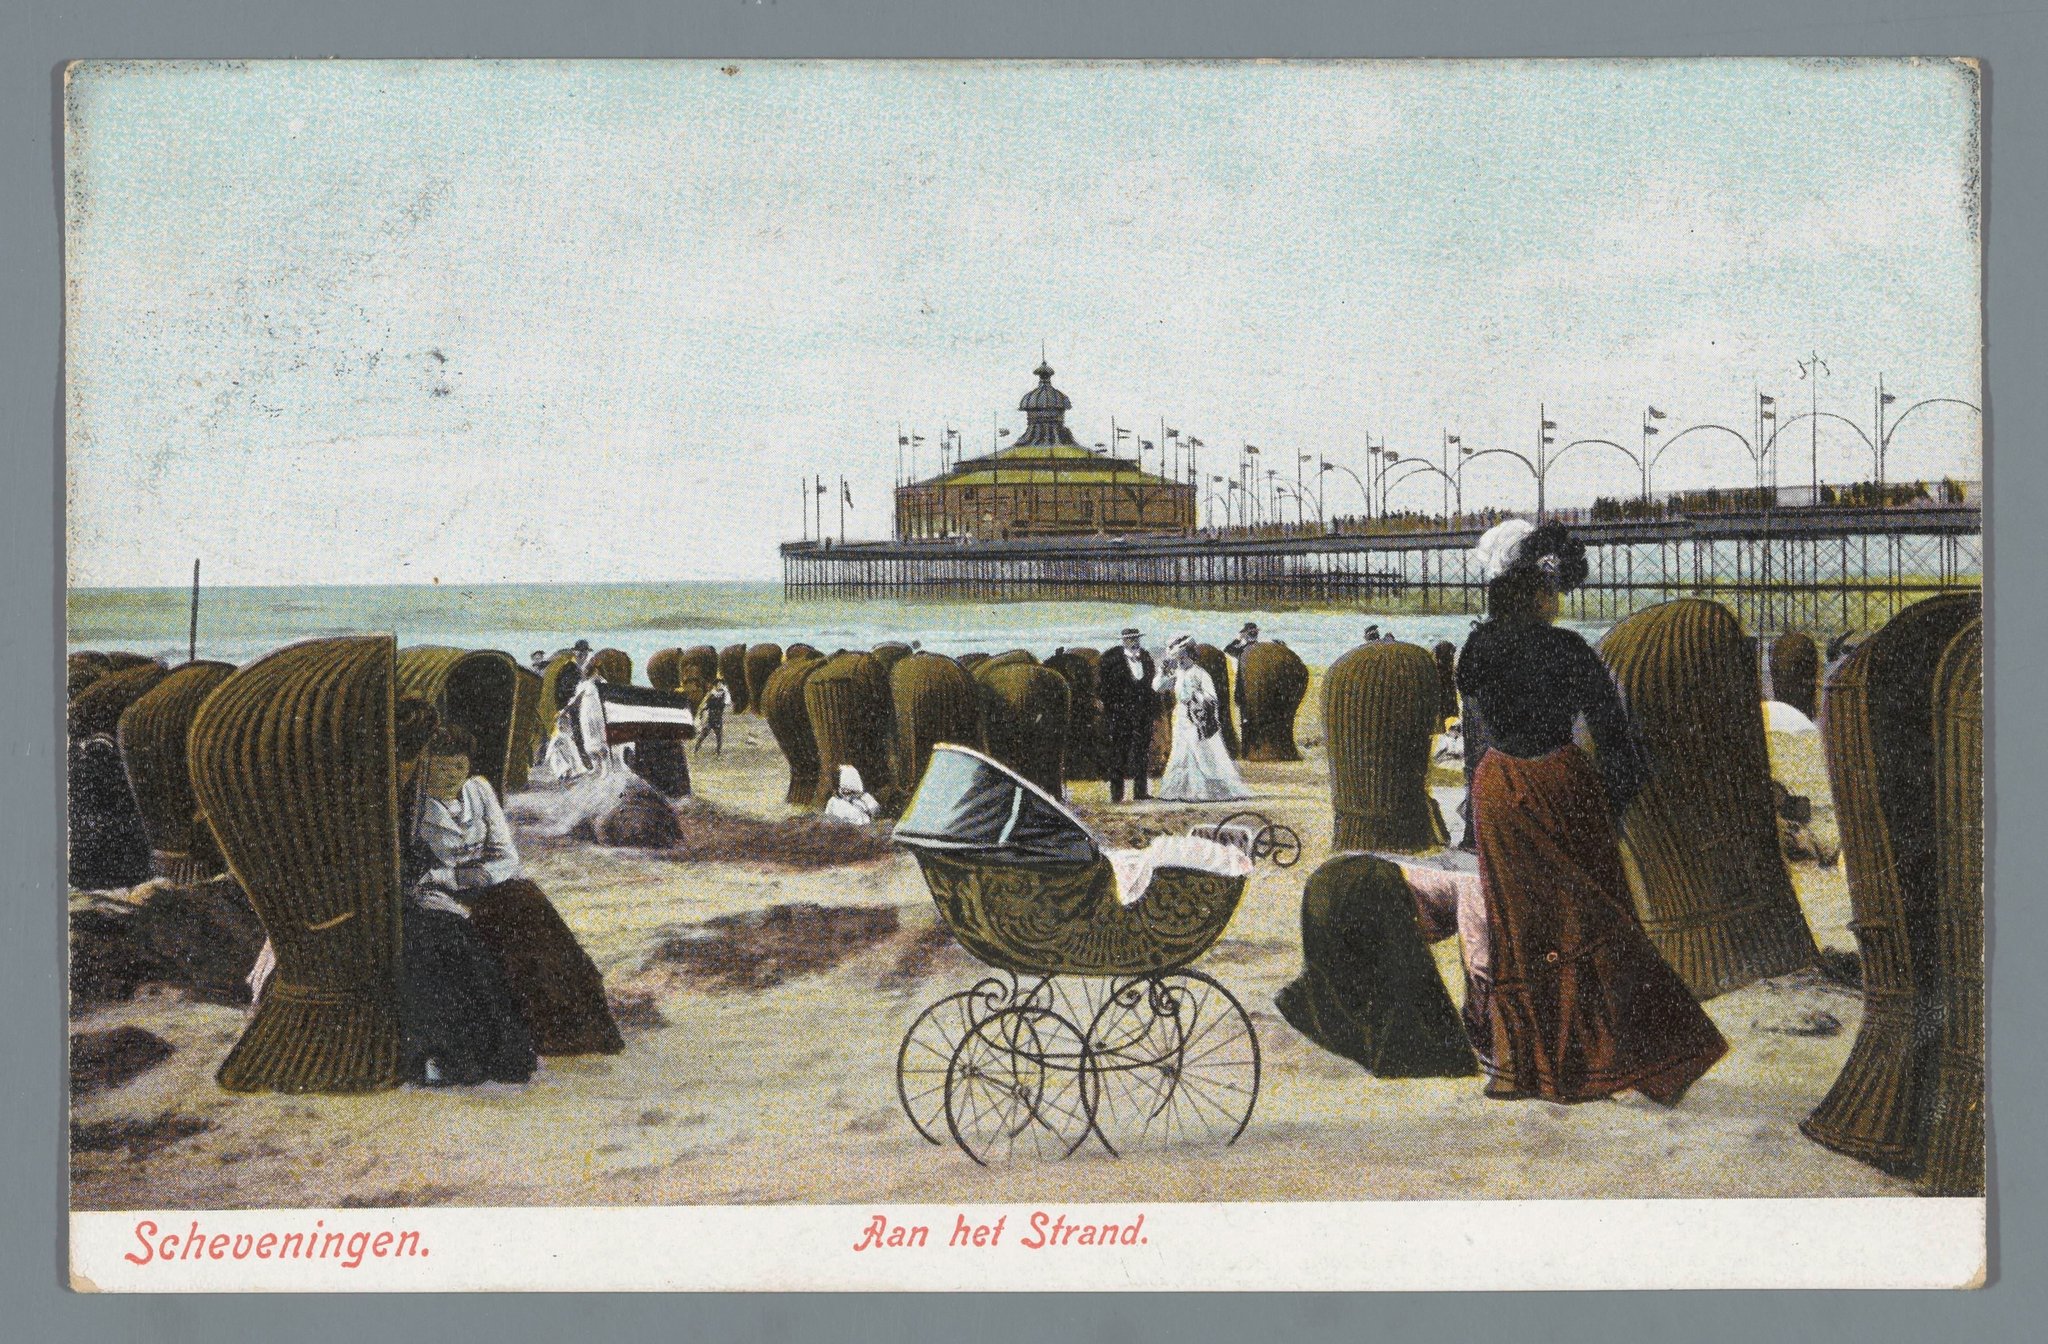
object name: ansichtkaart, prentbriefkaart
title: Scheveningen, Aan het Strand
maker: Anonymous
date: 1908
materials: cardboard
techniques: writing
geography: amsterdam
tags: coast